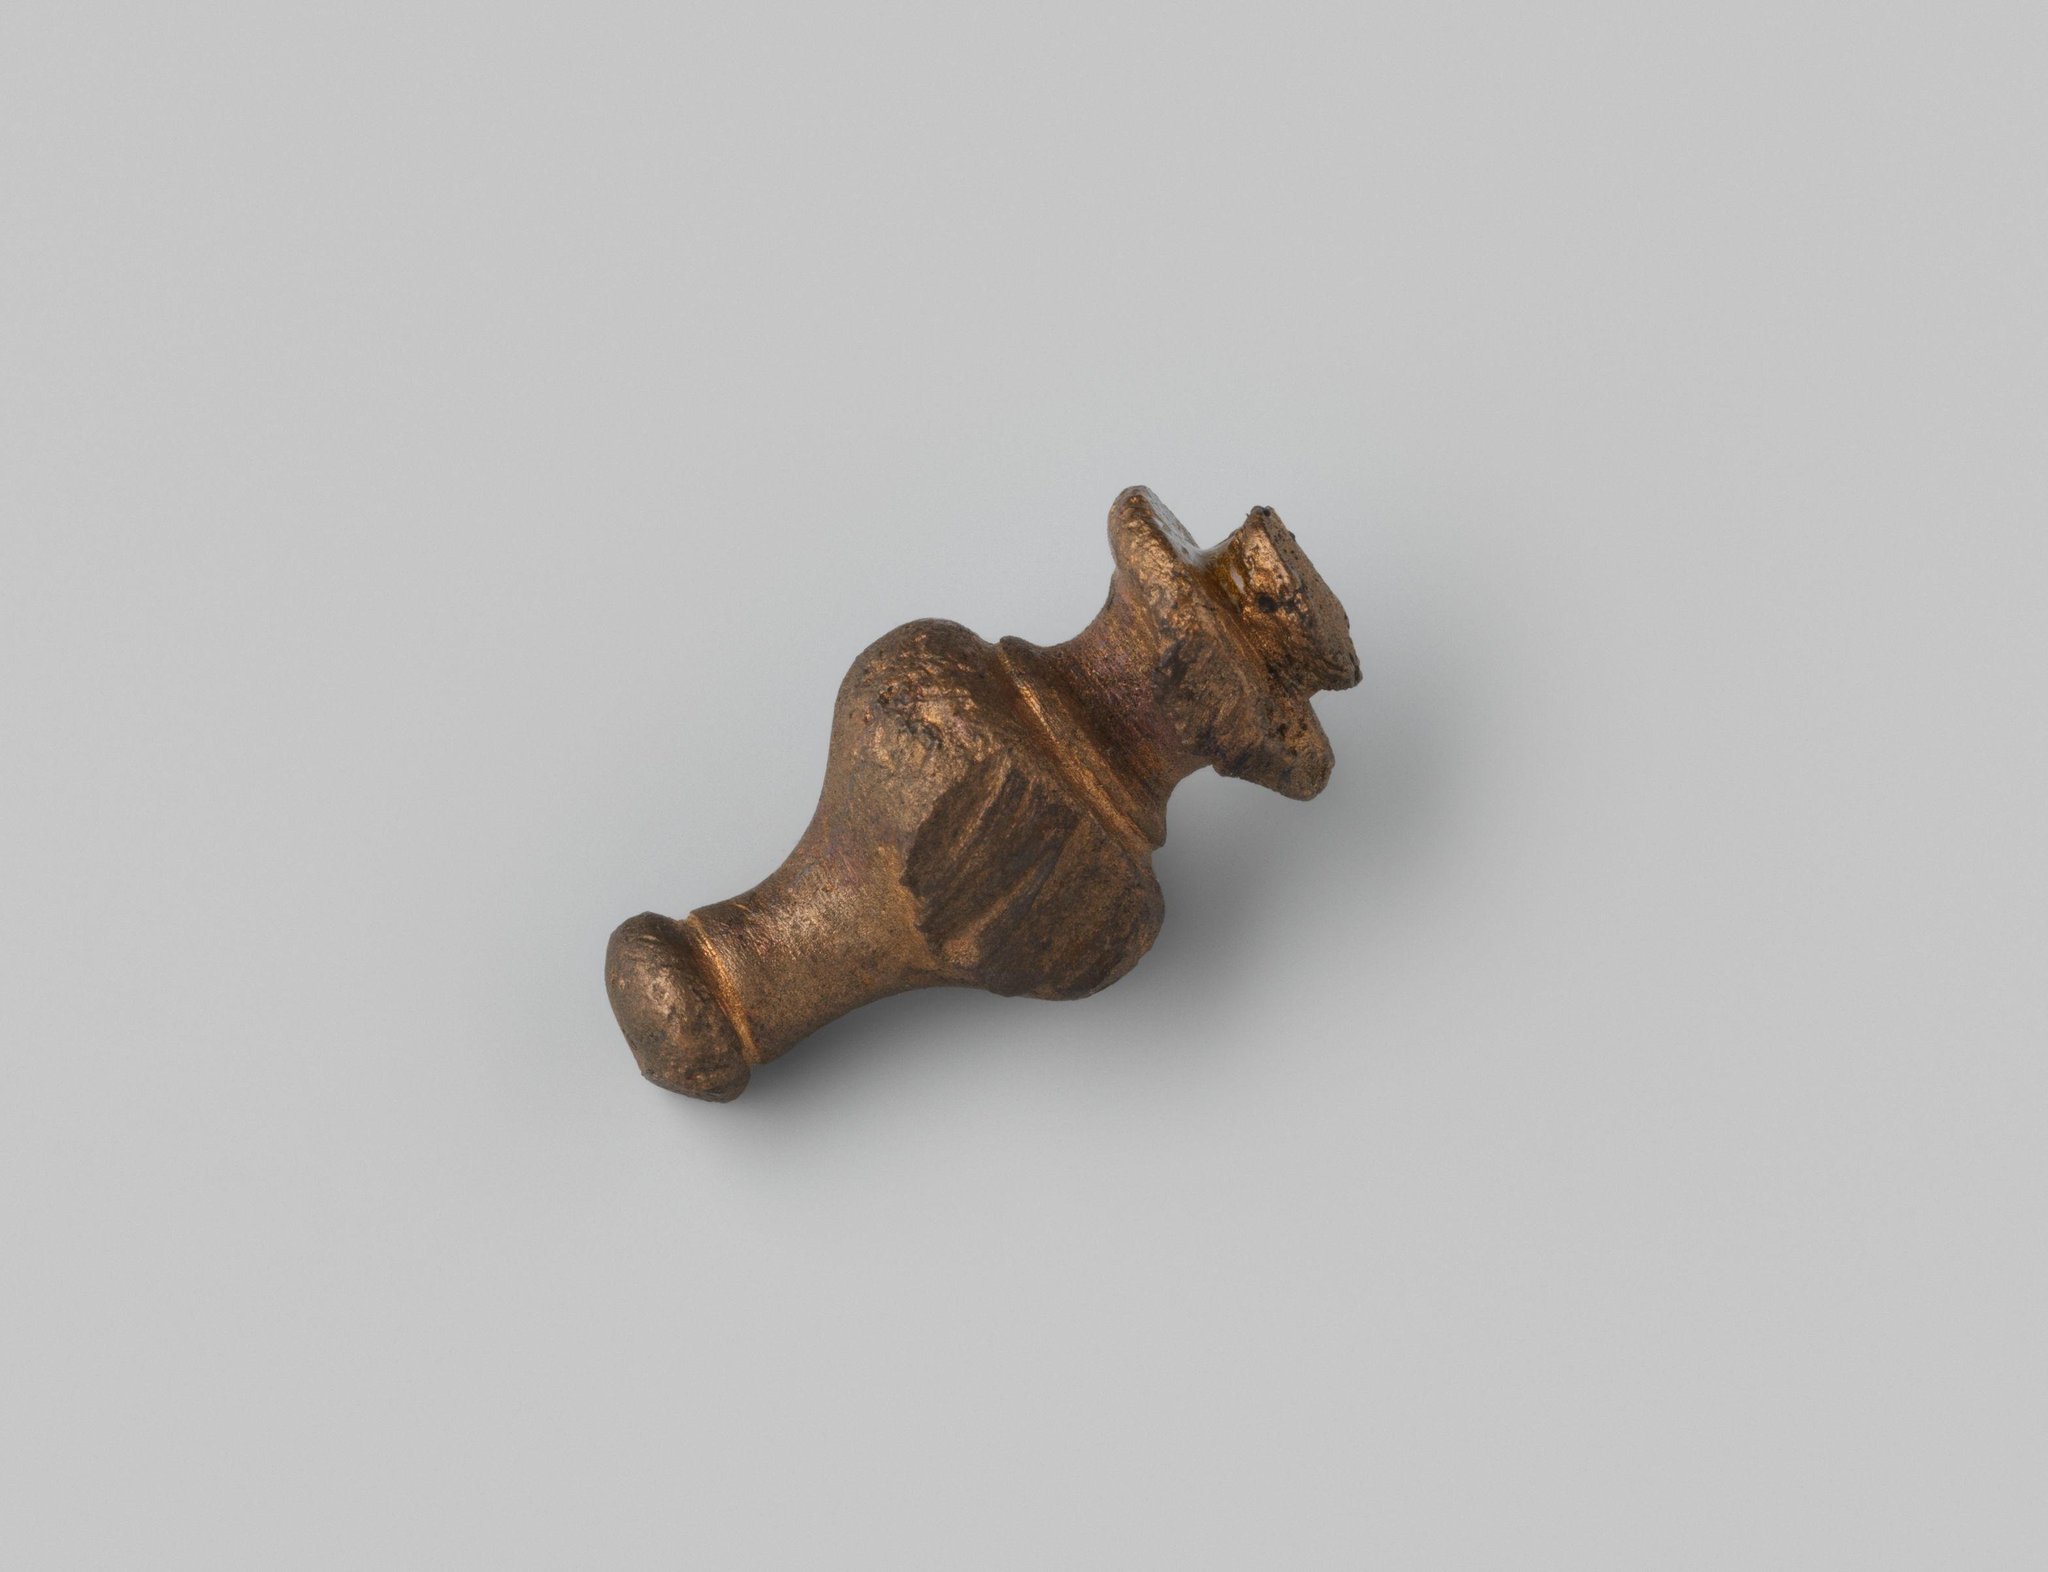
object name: knob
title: Knop uit het wrak van de Oost-Indiëvaarder Hollandia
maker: Anonymous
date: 1700-1743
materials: copper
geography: netherlands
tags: verenigde oostindische compagnie, hollandia (schip), annet